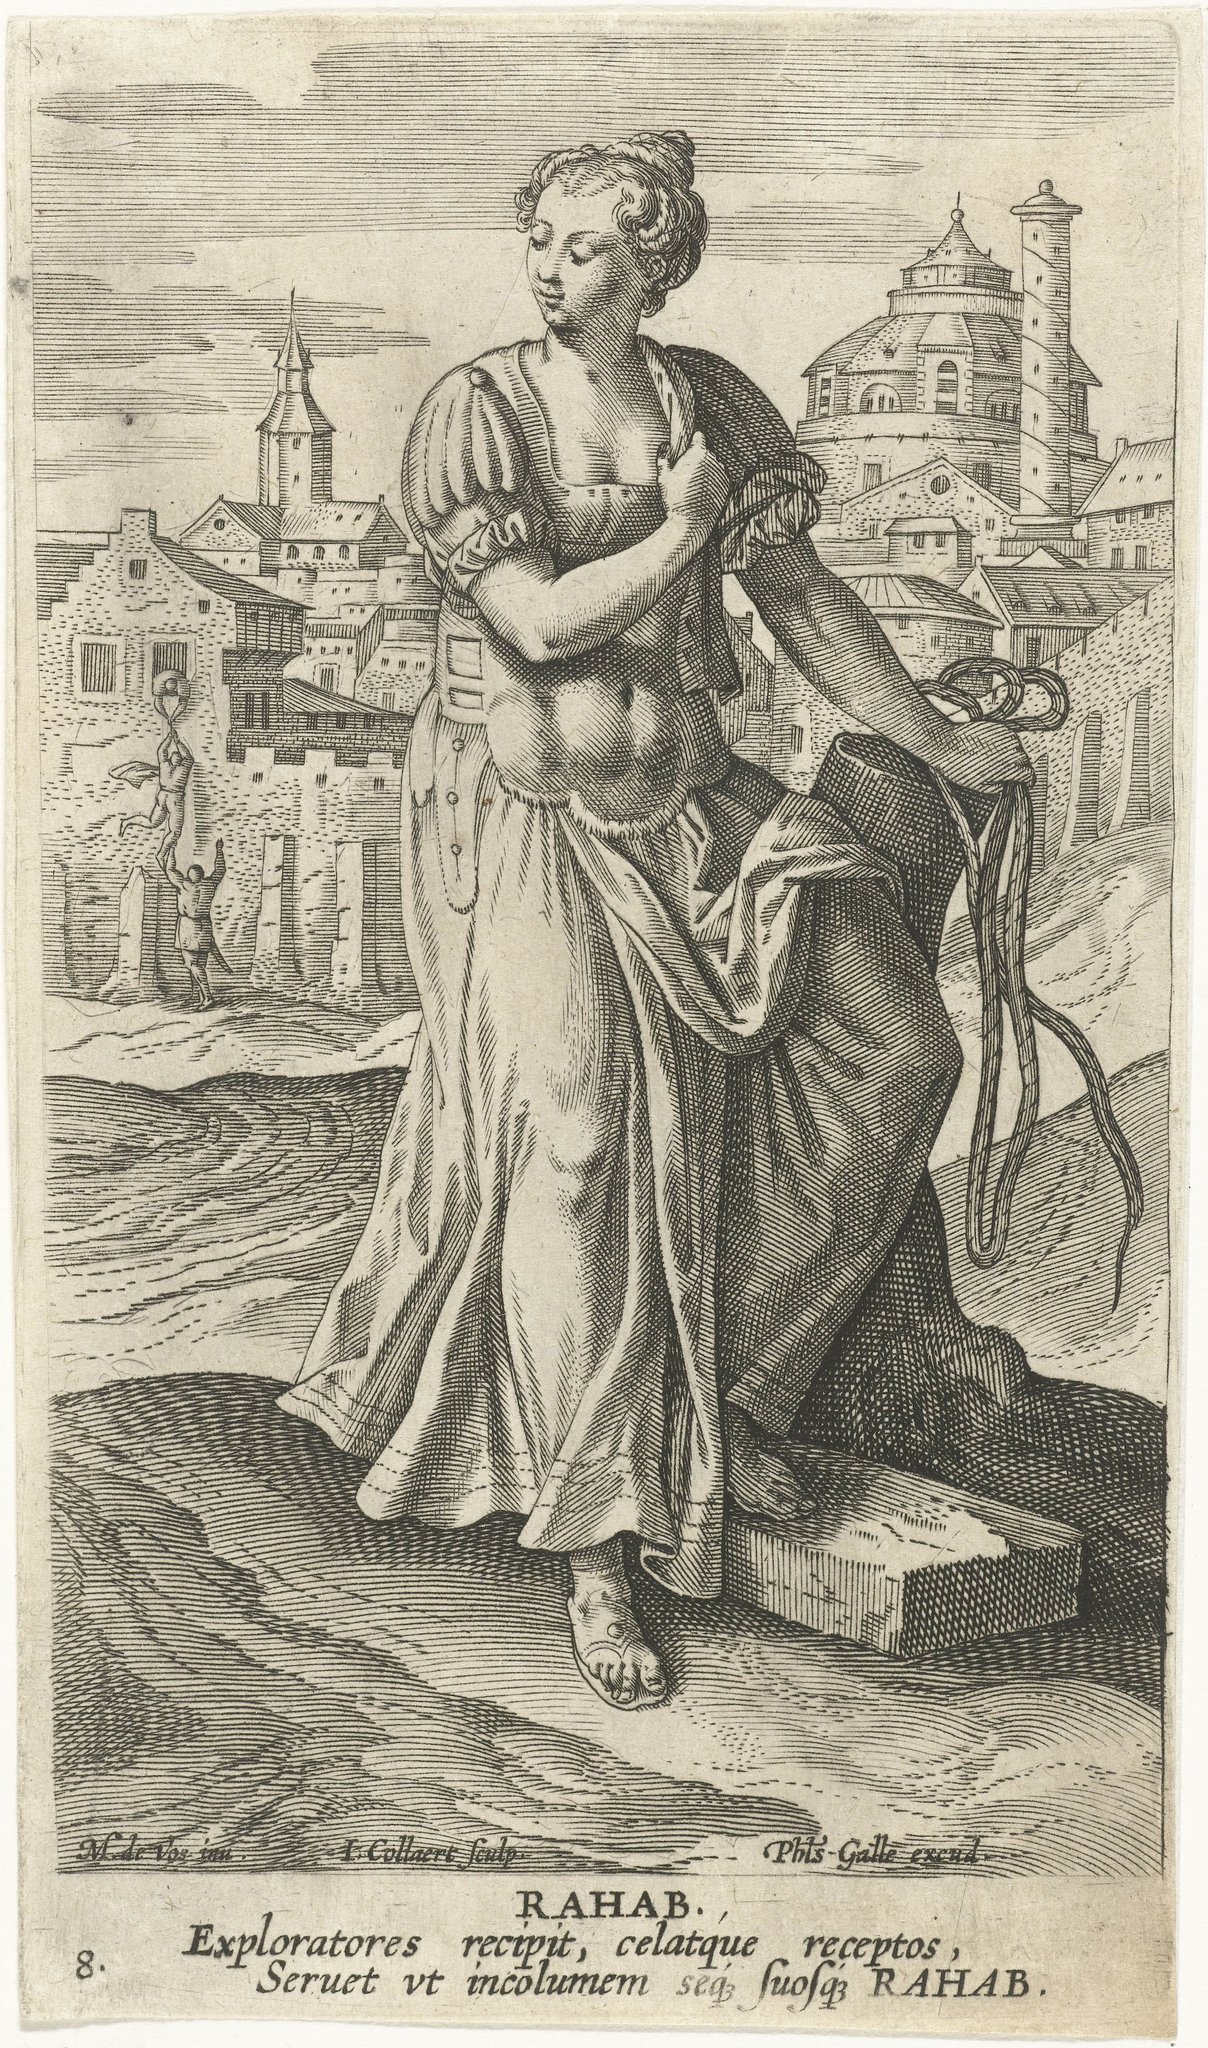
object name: print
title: Rahab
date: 1588-1595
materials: paper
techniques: engraving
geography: antwerp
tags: rahab, whose house was built in the city wall, lets the spies down from the window by means of a red rope, rahab (not in biblical context); possible attributes: red rope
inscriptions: collector's mark: Lugt 2228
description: Op de voorgrond Rachab, een prostituee uit Jericho. Op de achtergrond helpt Rachab twee spionnen van het Israëlitische volk ontsnappen uit de stad Jericho door hen uit een raam te laten zakken. De prent heeft een Latijns onderschrift en maakt deel uit van een prentserie met beroemde vrouwen uit het Oude Testament.